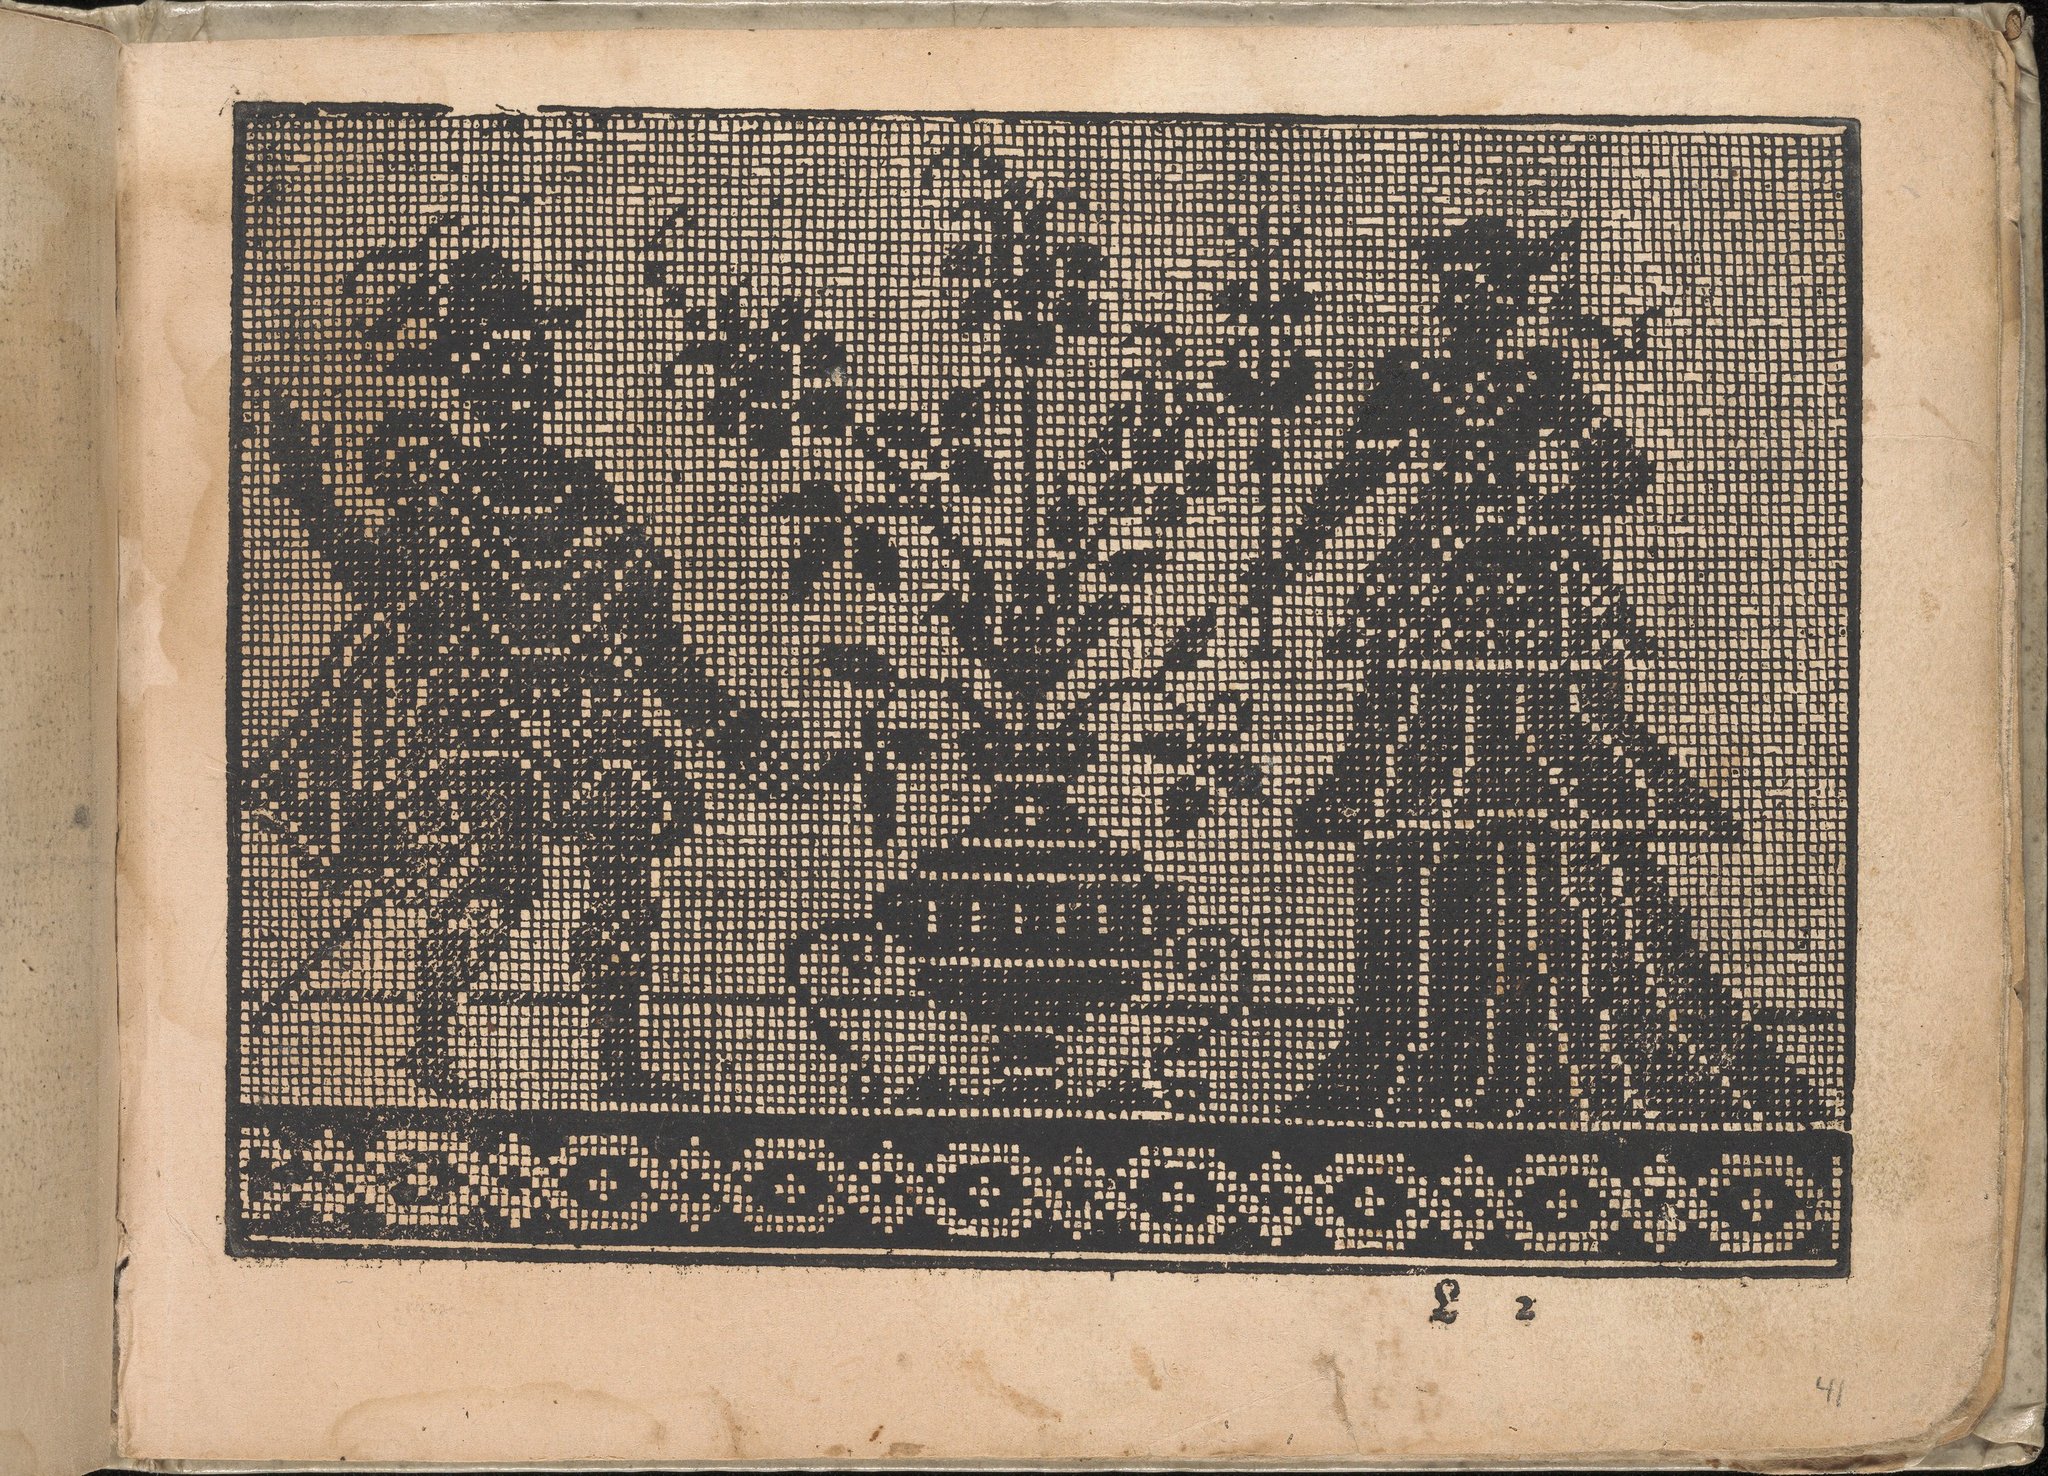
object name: book print ornament architecture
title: Neu künstlich Modelbuch (page 41r)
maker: bernhard jobin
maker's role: publisher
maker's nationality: swiss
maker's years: 1535-1597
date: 1598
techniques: woodcut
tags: men,women,plants